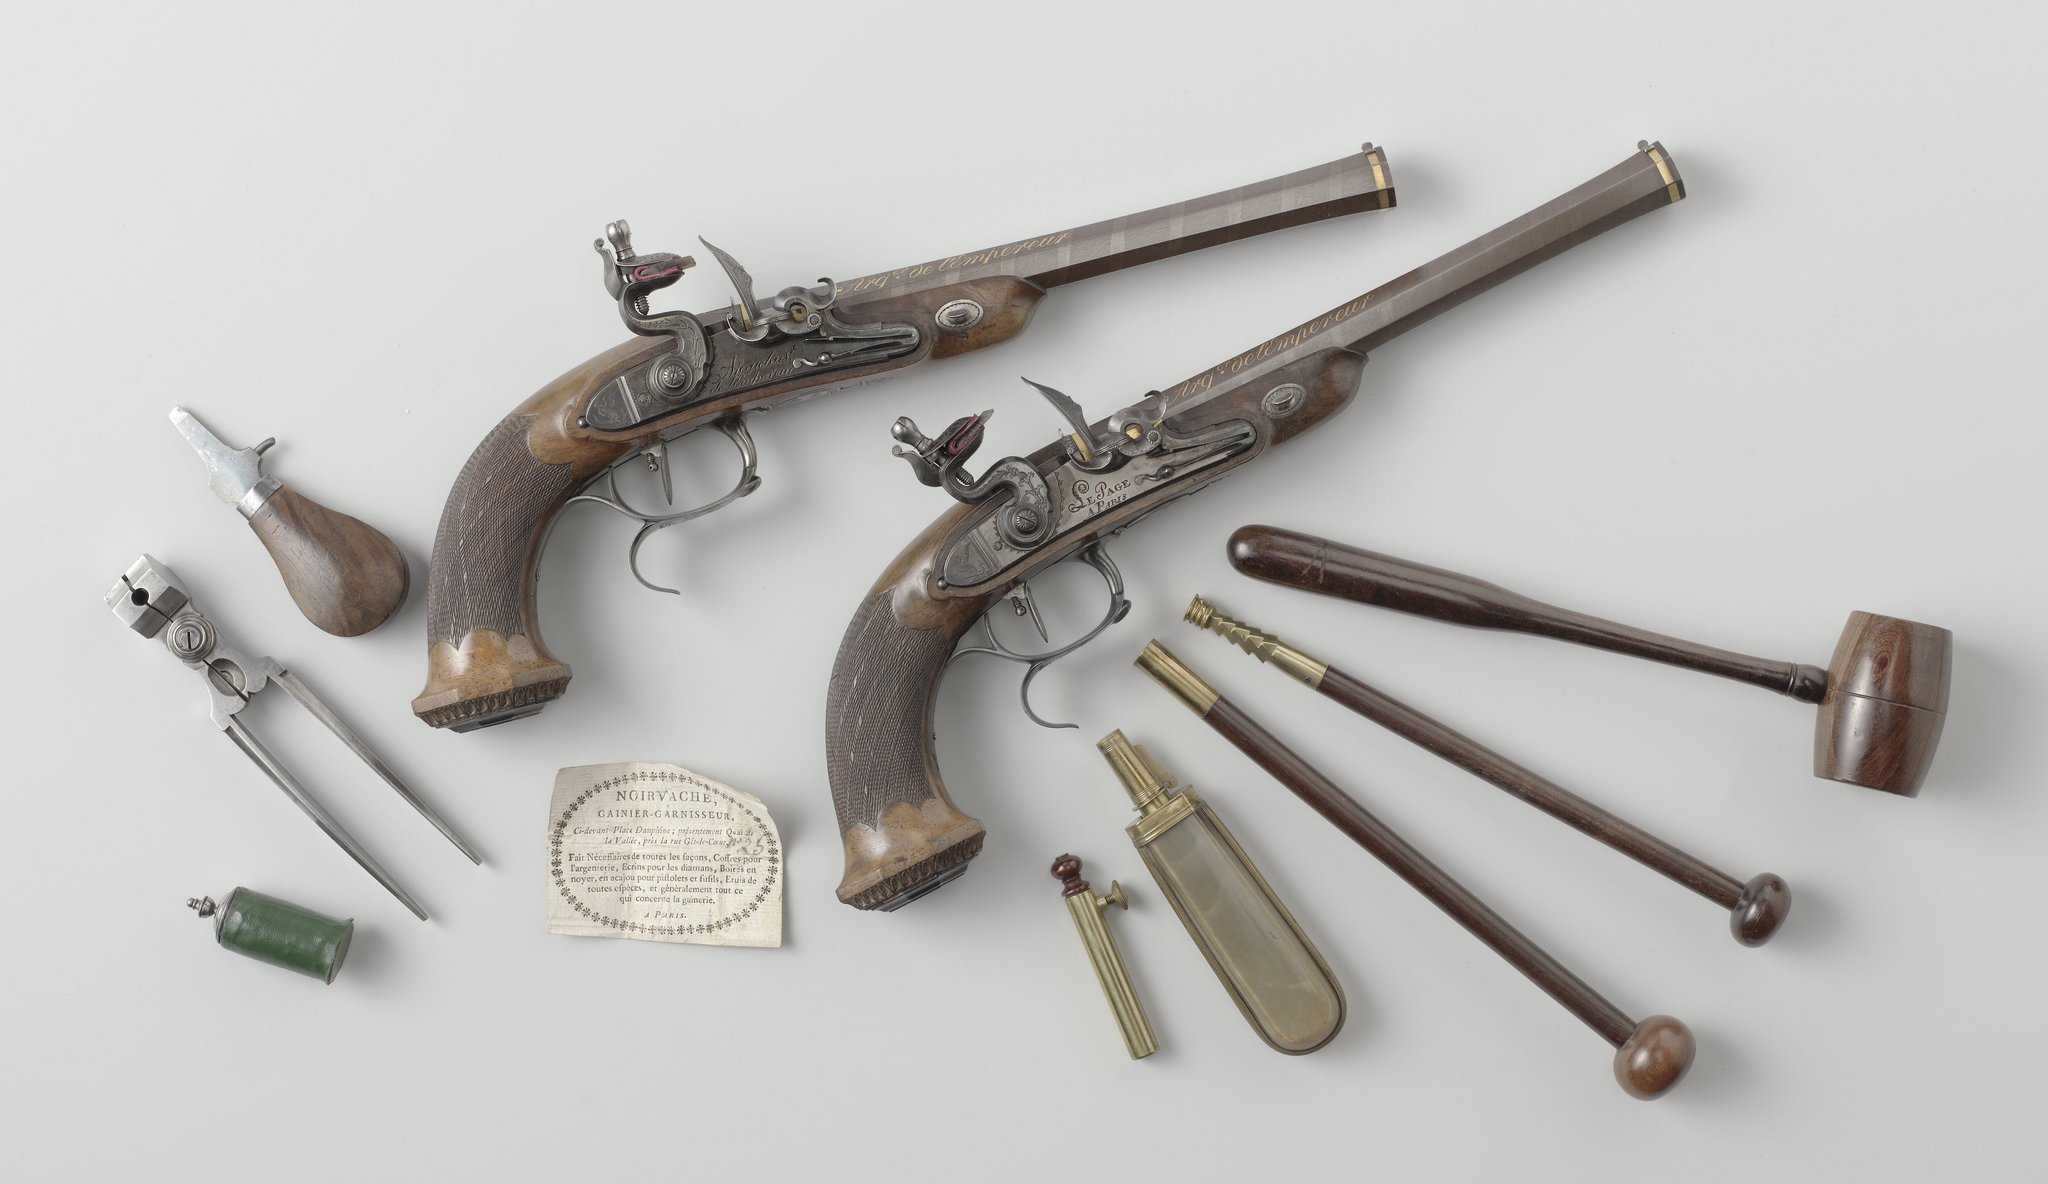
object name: rammer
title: Kruithoorn, kogelgiettang, bus, laadstok, schoonmaakstok, hamer, schroevendraaier e.a.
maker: jean le page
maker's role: geweermaker, pistoolmaker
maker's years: 1746-1834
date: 1808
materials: brass, leather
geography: paris